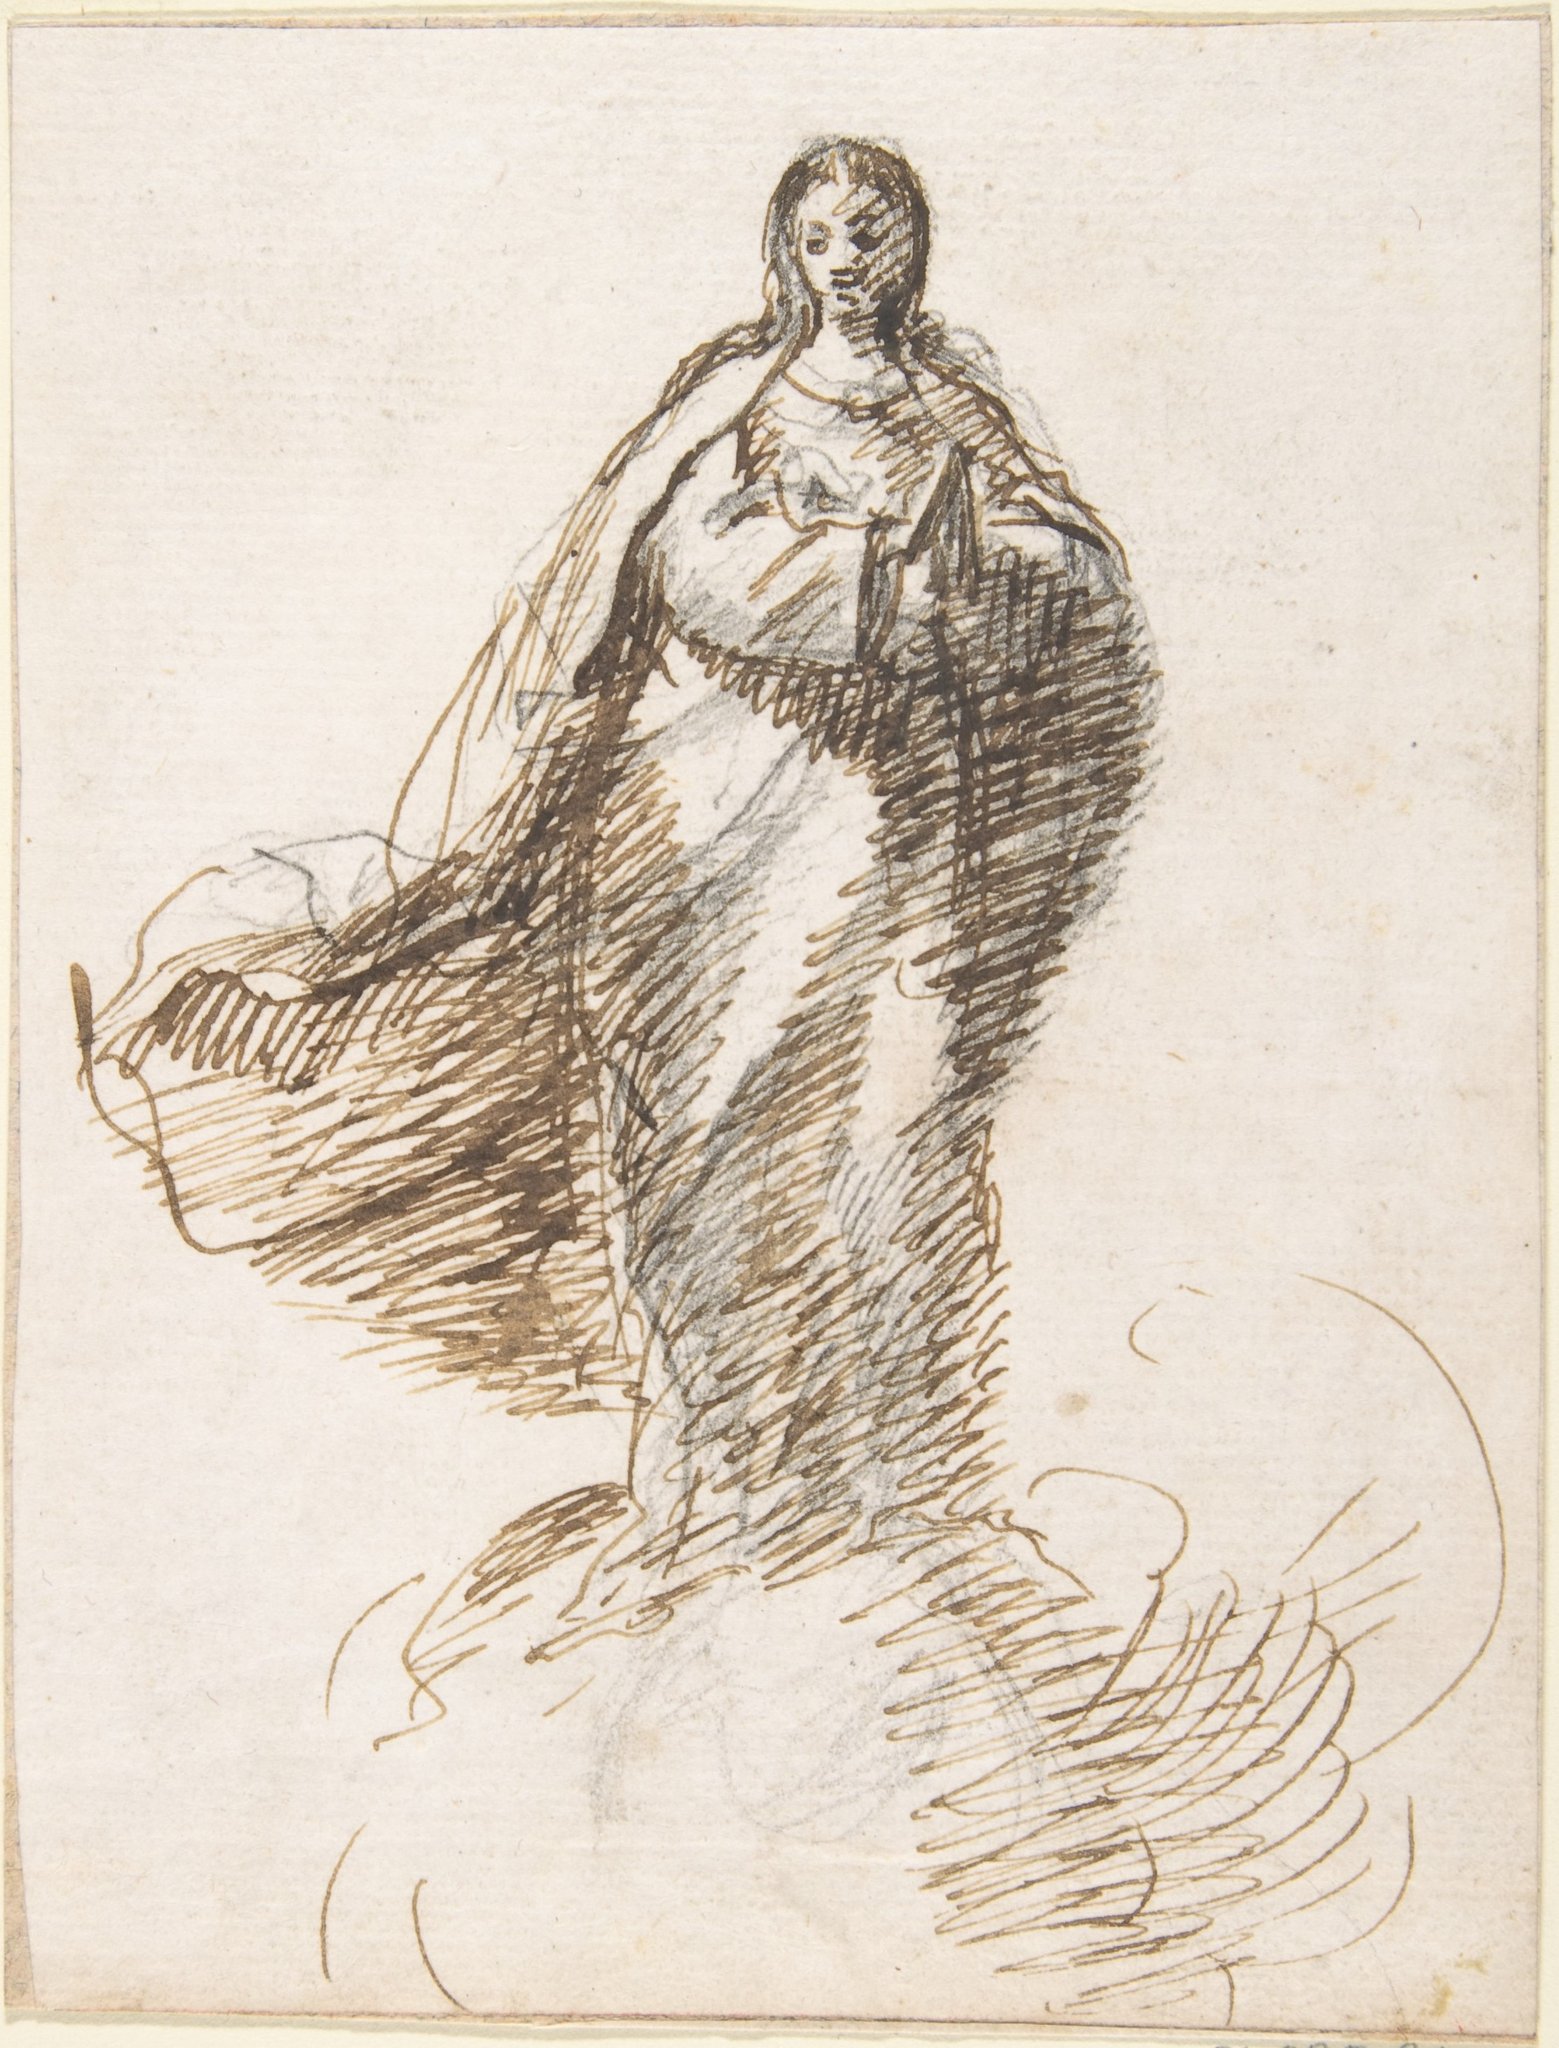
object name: drawing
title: Virgin of the Immaculate Conception Standing on Clouds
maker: pedro duque cornejo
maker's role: artist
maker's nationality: spanish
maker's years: 1677-1757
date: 1700-1750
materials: chalk, ink, paper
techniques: pen, drawing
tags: virgin mary